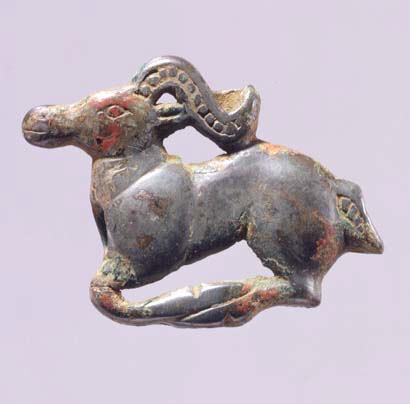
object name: harness ornament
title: Harness Ornament in the Shape of Gazelle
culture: chinese, northeast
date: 600-401 BCE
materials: bronze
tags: deer